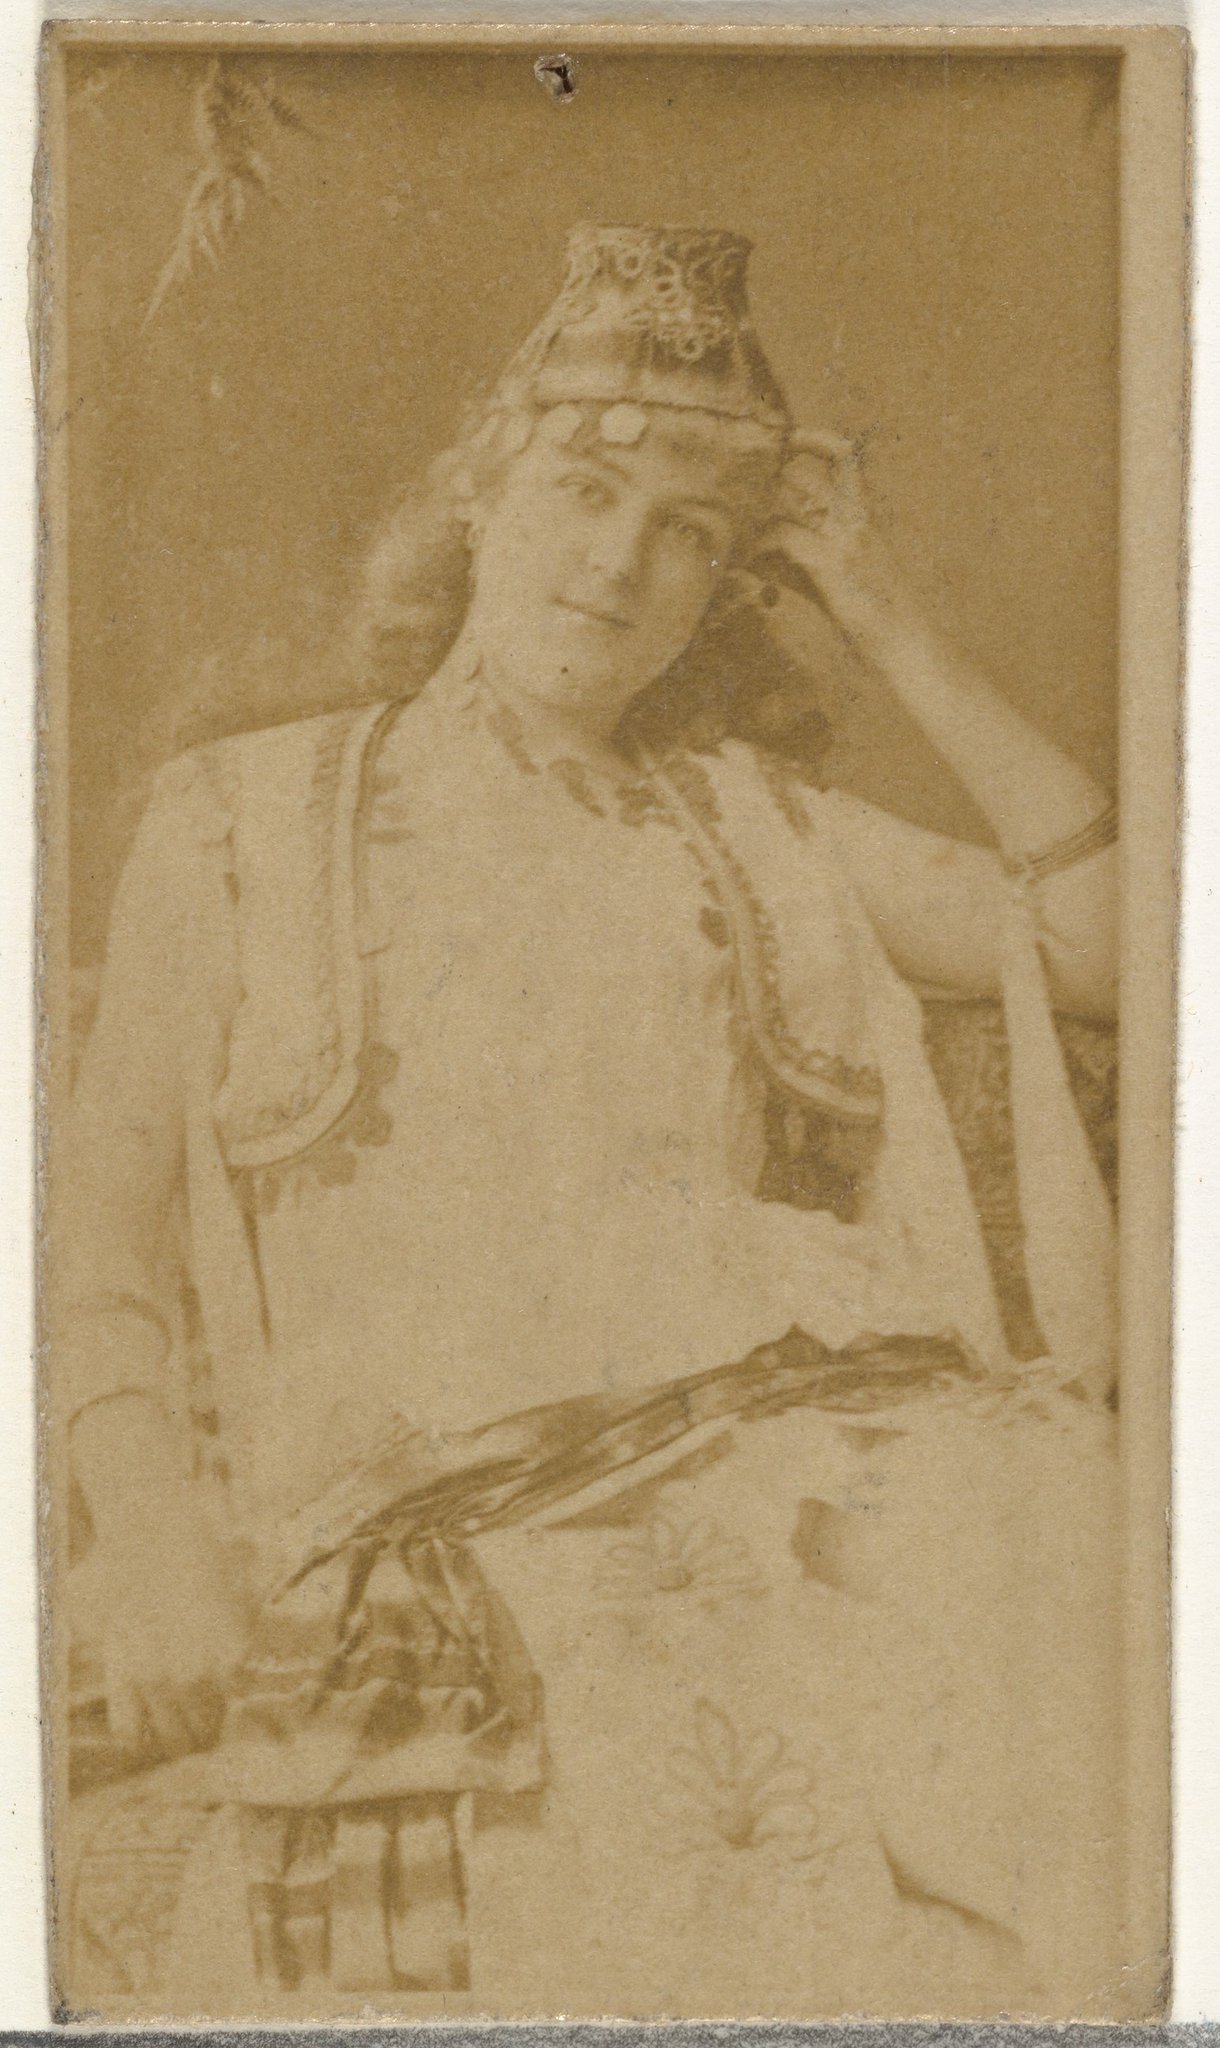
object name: photograph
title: [Actress wearing exotic costume], from the Actors and Actresses series (N145-8) issued by Duke Sons & Co. to promote Duke Cigarettes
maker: w. duke, sons & co.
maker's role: publisher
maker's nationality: american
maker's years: 1870-1920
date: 1891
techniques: albumen silver print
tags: portraits,women,actresses